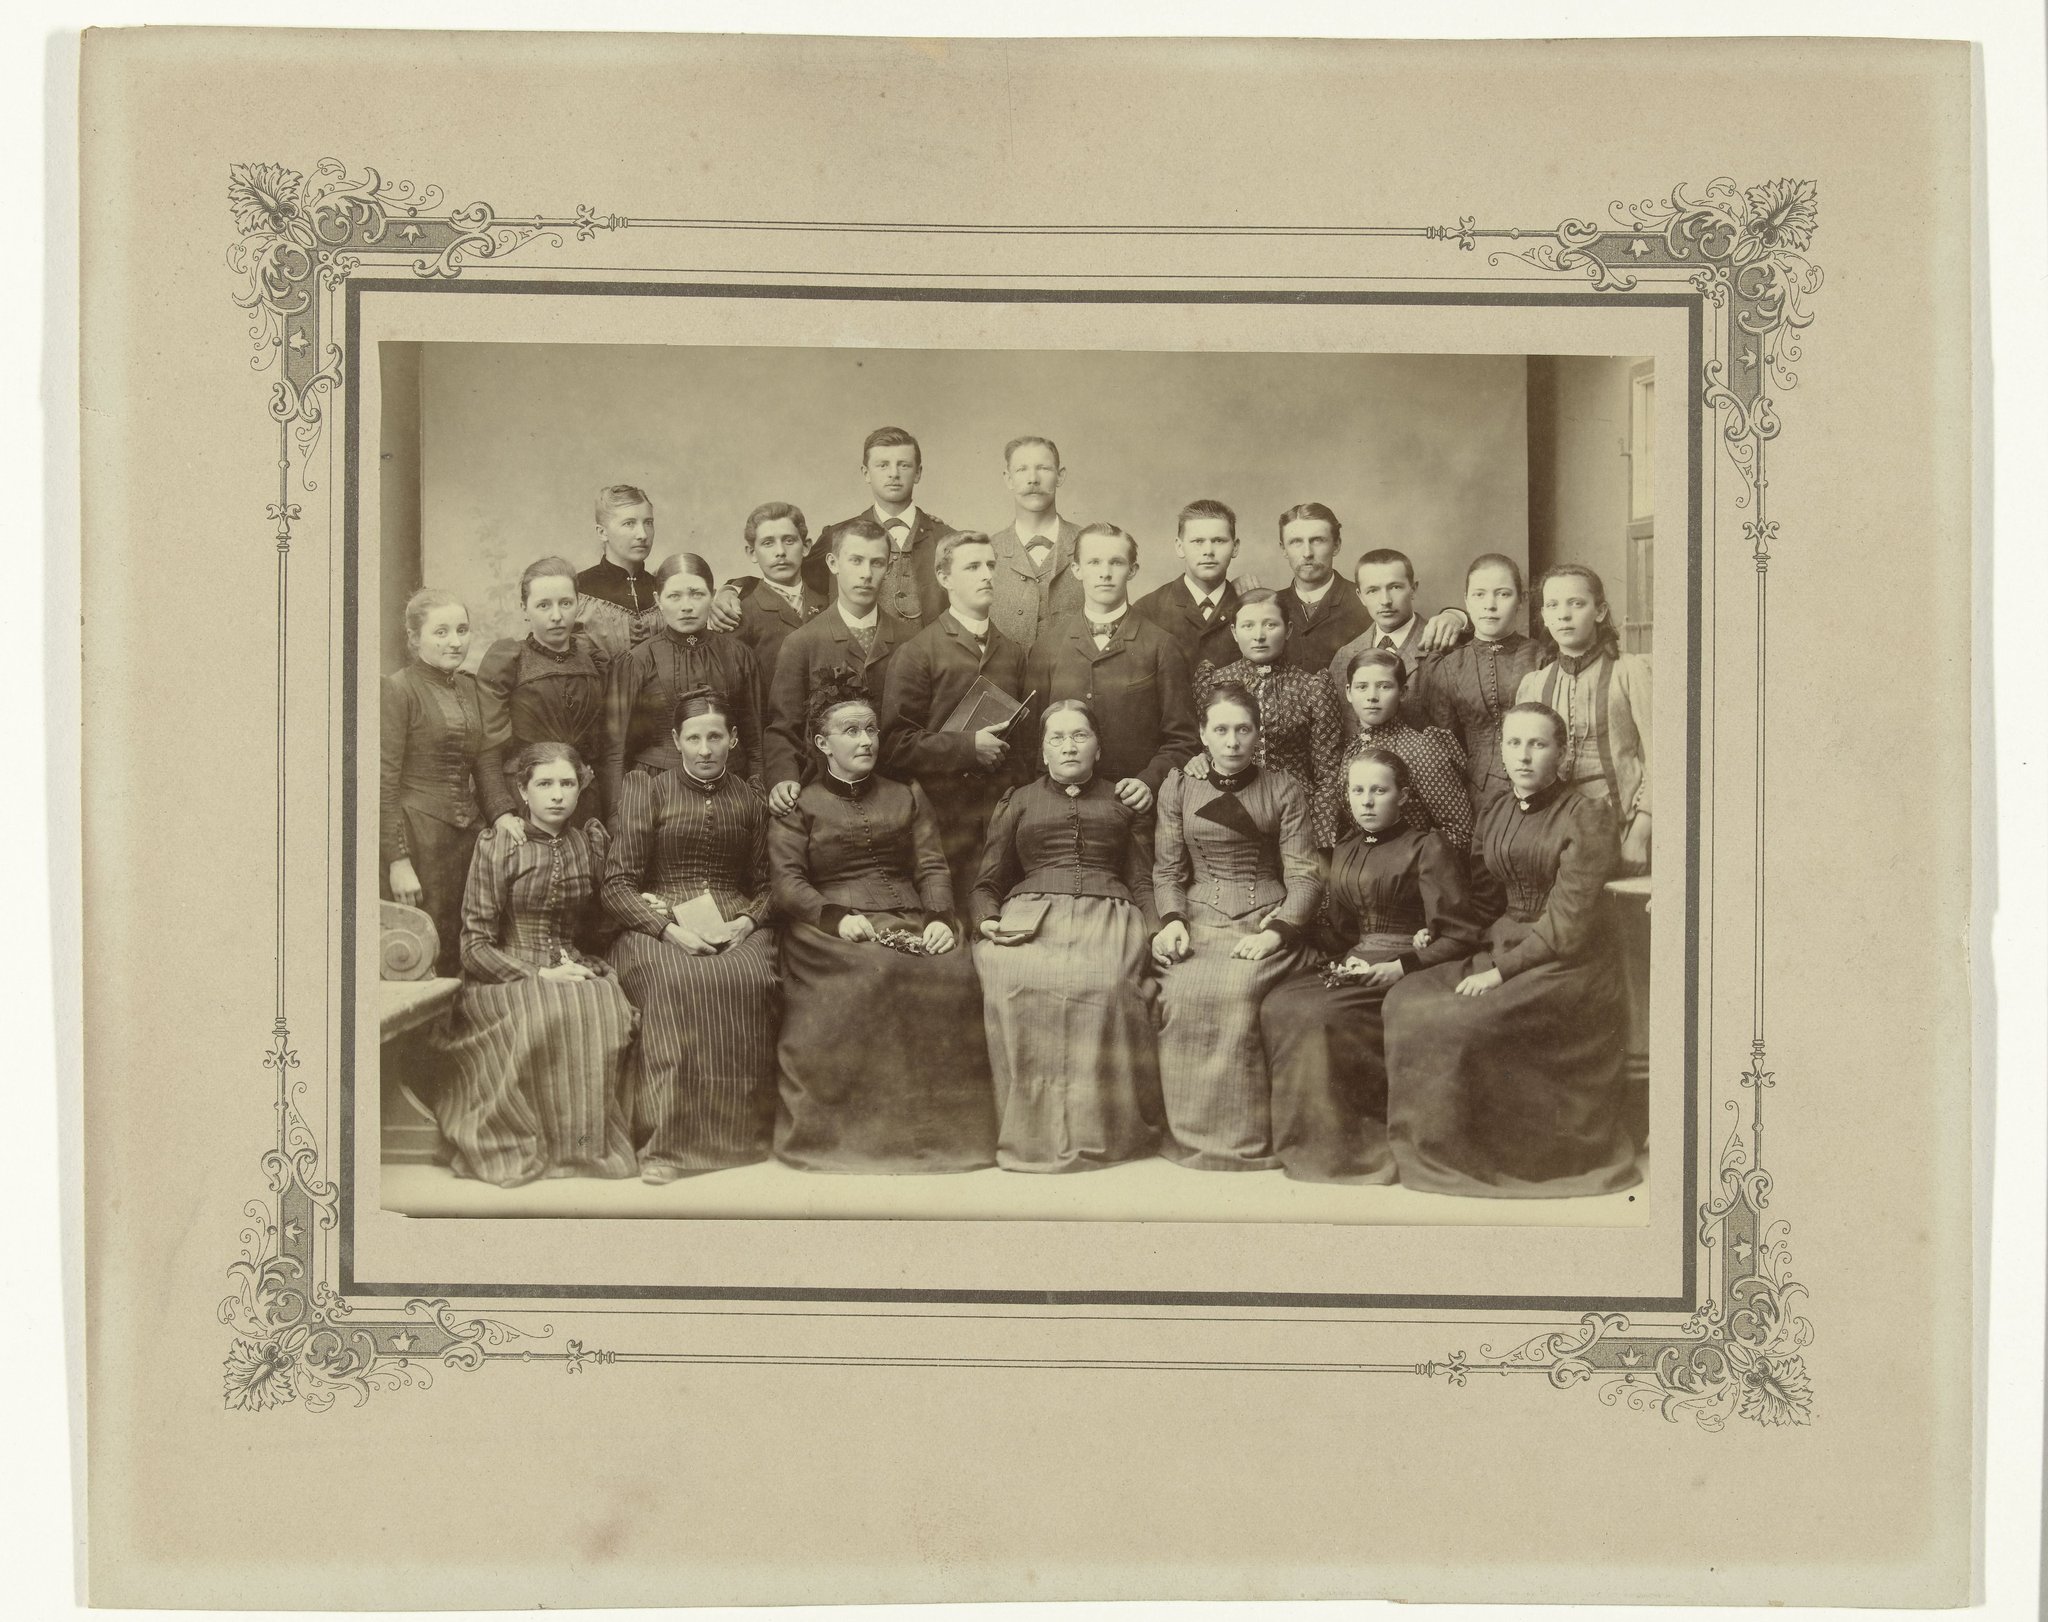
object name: photograph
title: Studioportret van een familie, genomen voor een achtergronddoek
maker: Anonymous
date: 1880-1900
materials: paper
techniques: albumen print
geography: netherlands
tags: family group, especially parents with their child(ren)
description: Op de voorste rij zitten alleen maar vrouwen, de mannen staan achteraan.